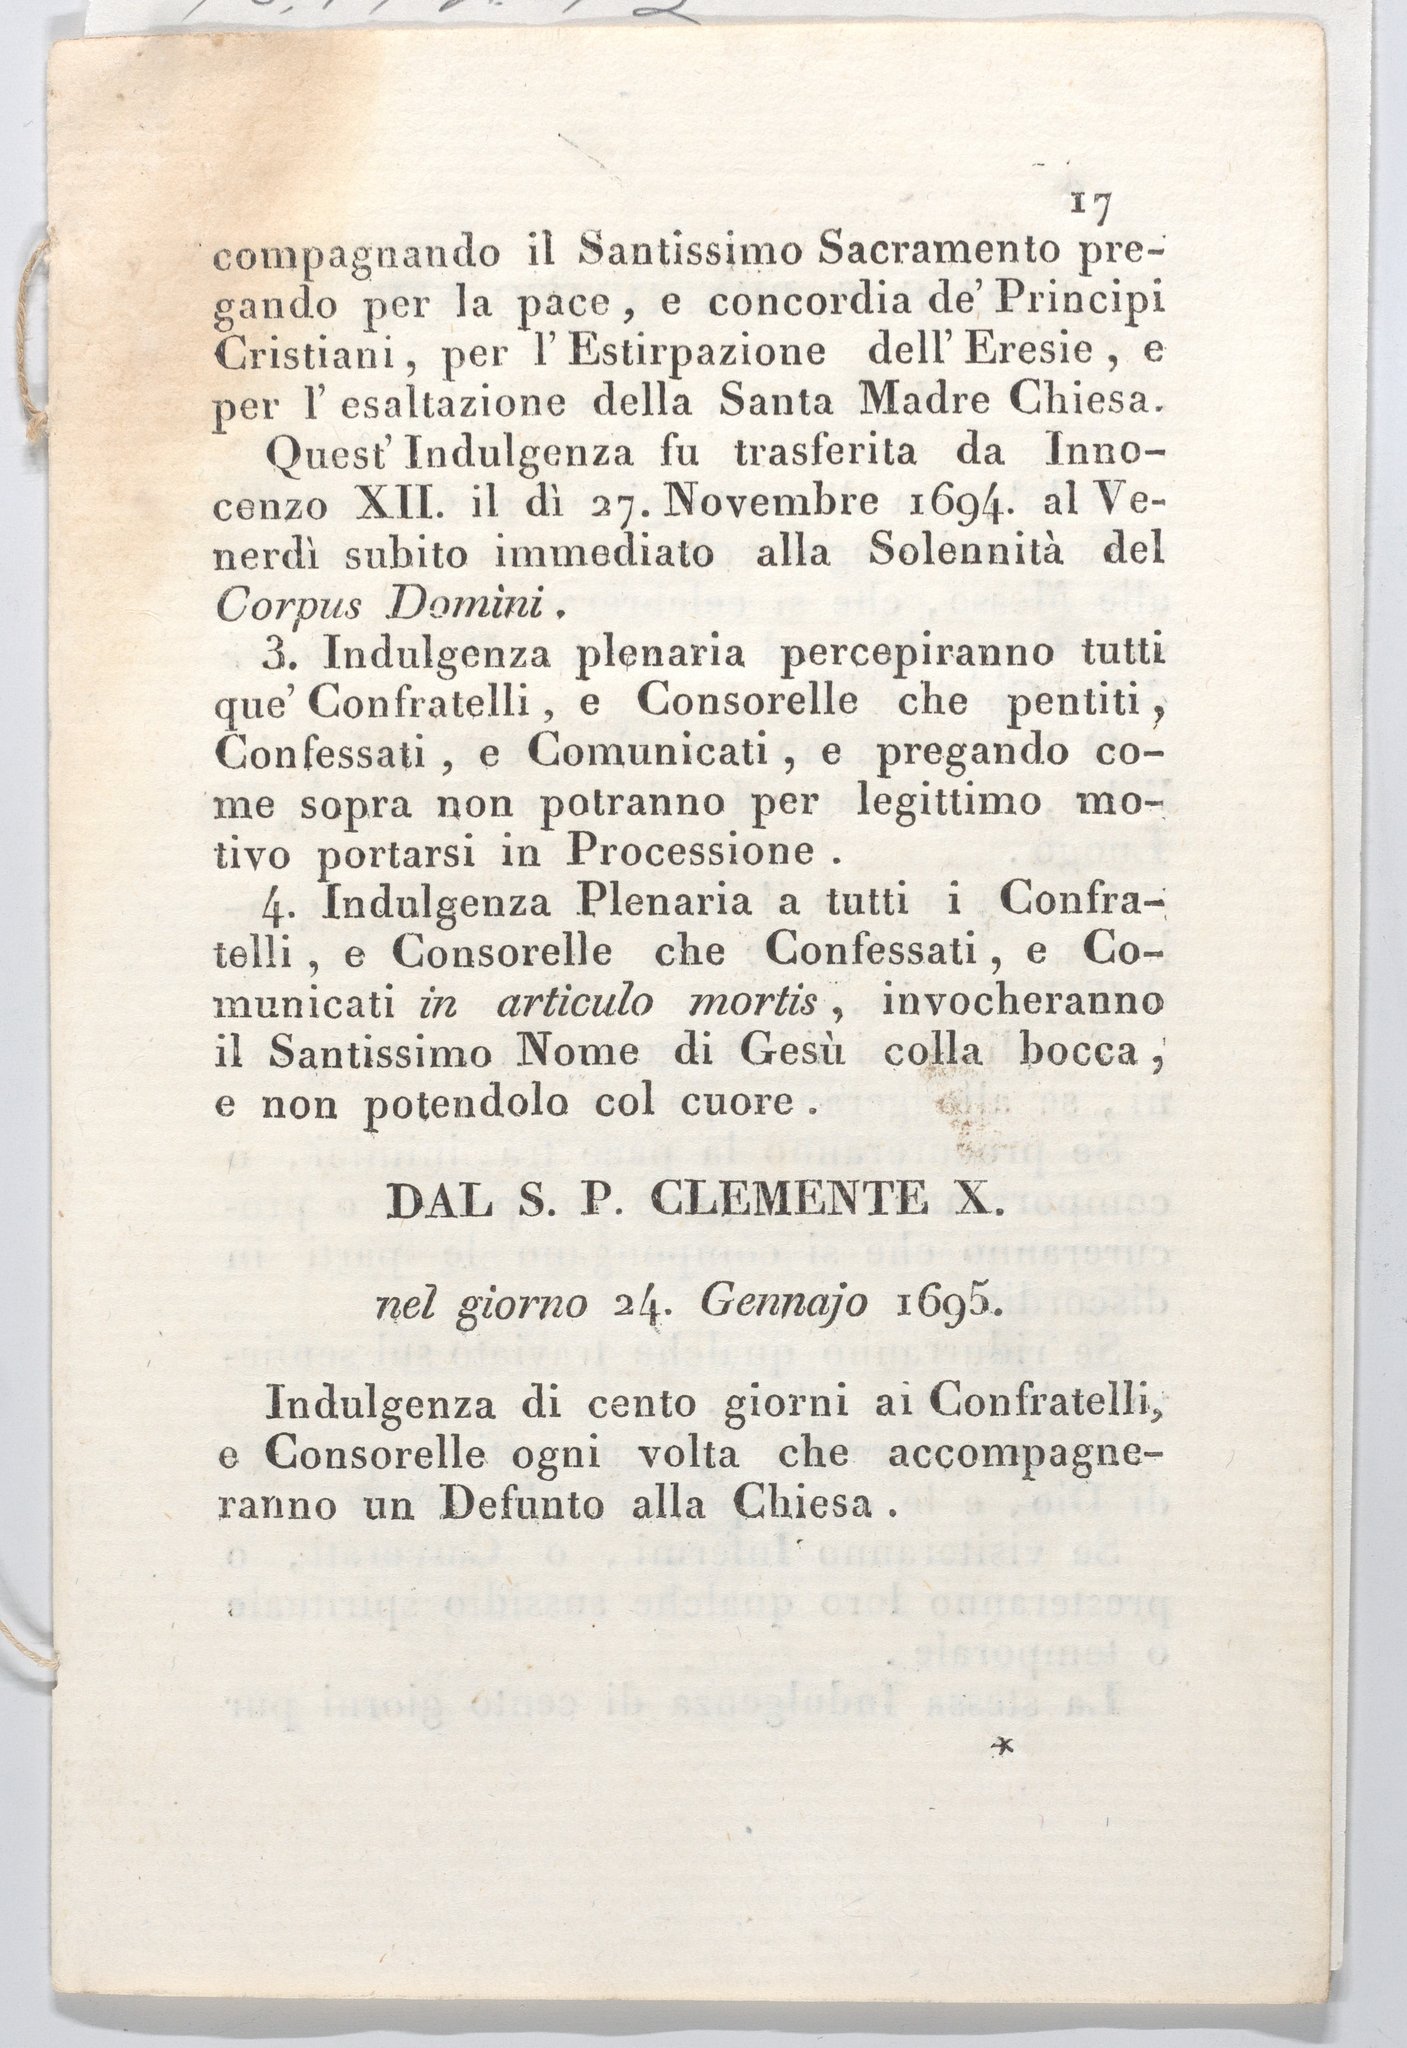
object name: print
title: Book cover for Volpi's Poesie with red and blue floral, paisley, and geometric patterns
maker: remondini family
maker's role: artist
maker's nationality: italian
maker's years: 1649-1861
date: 1701-1800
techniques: relief print